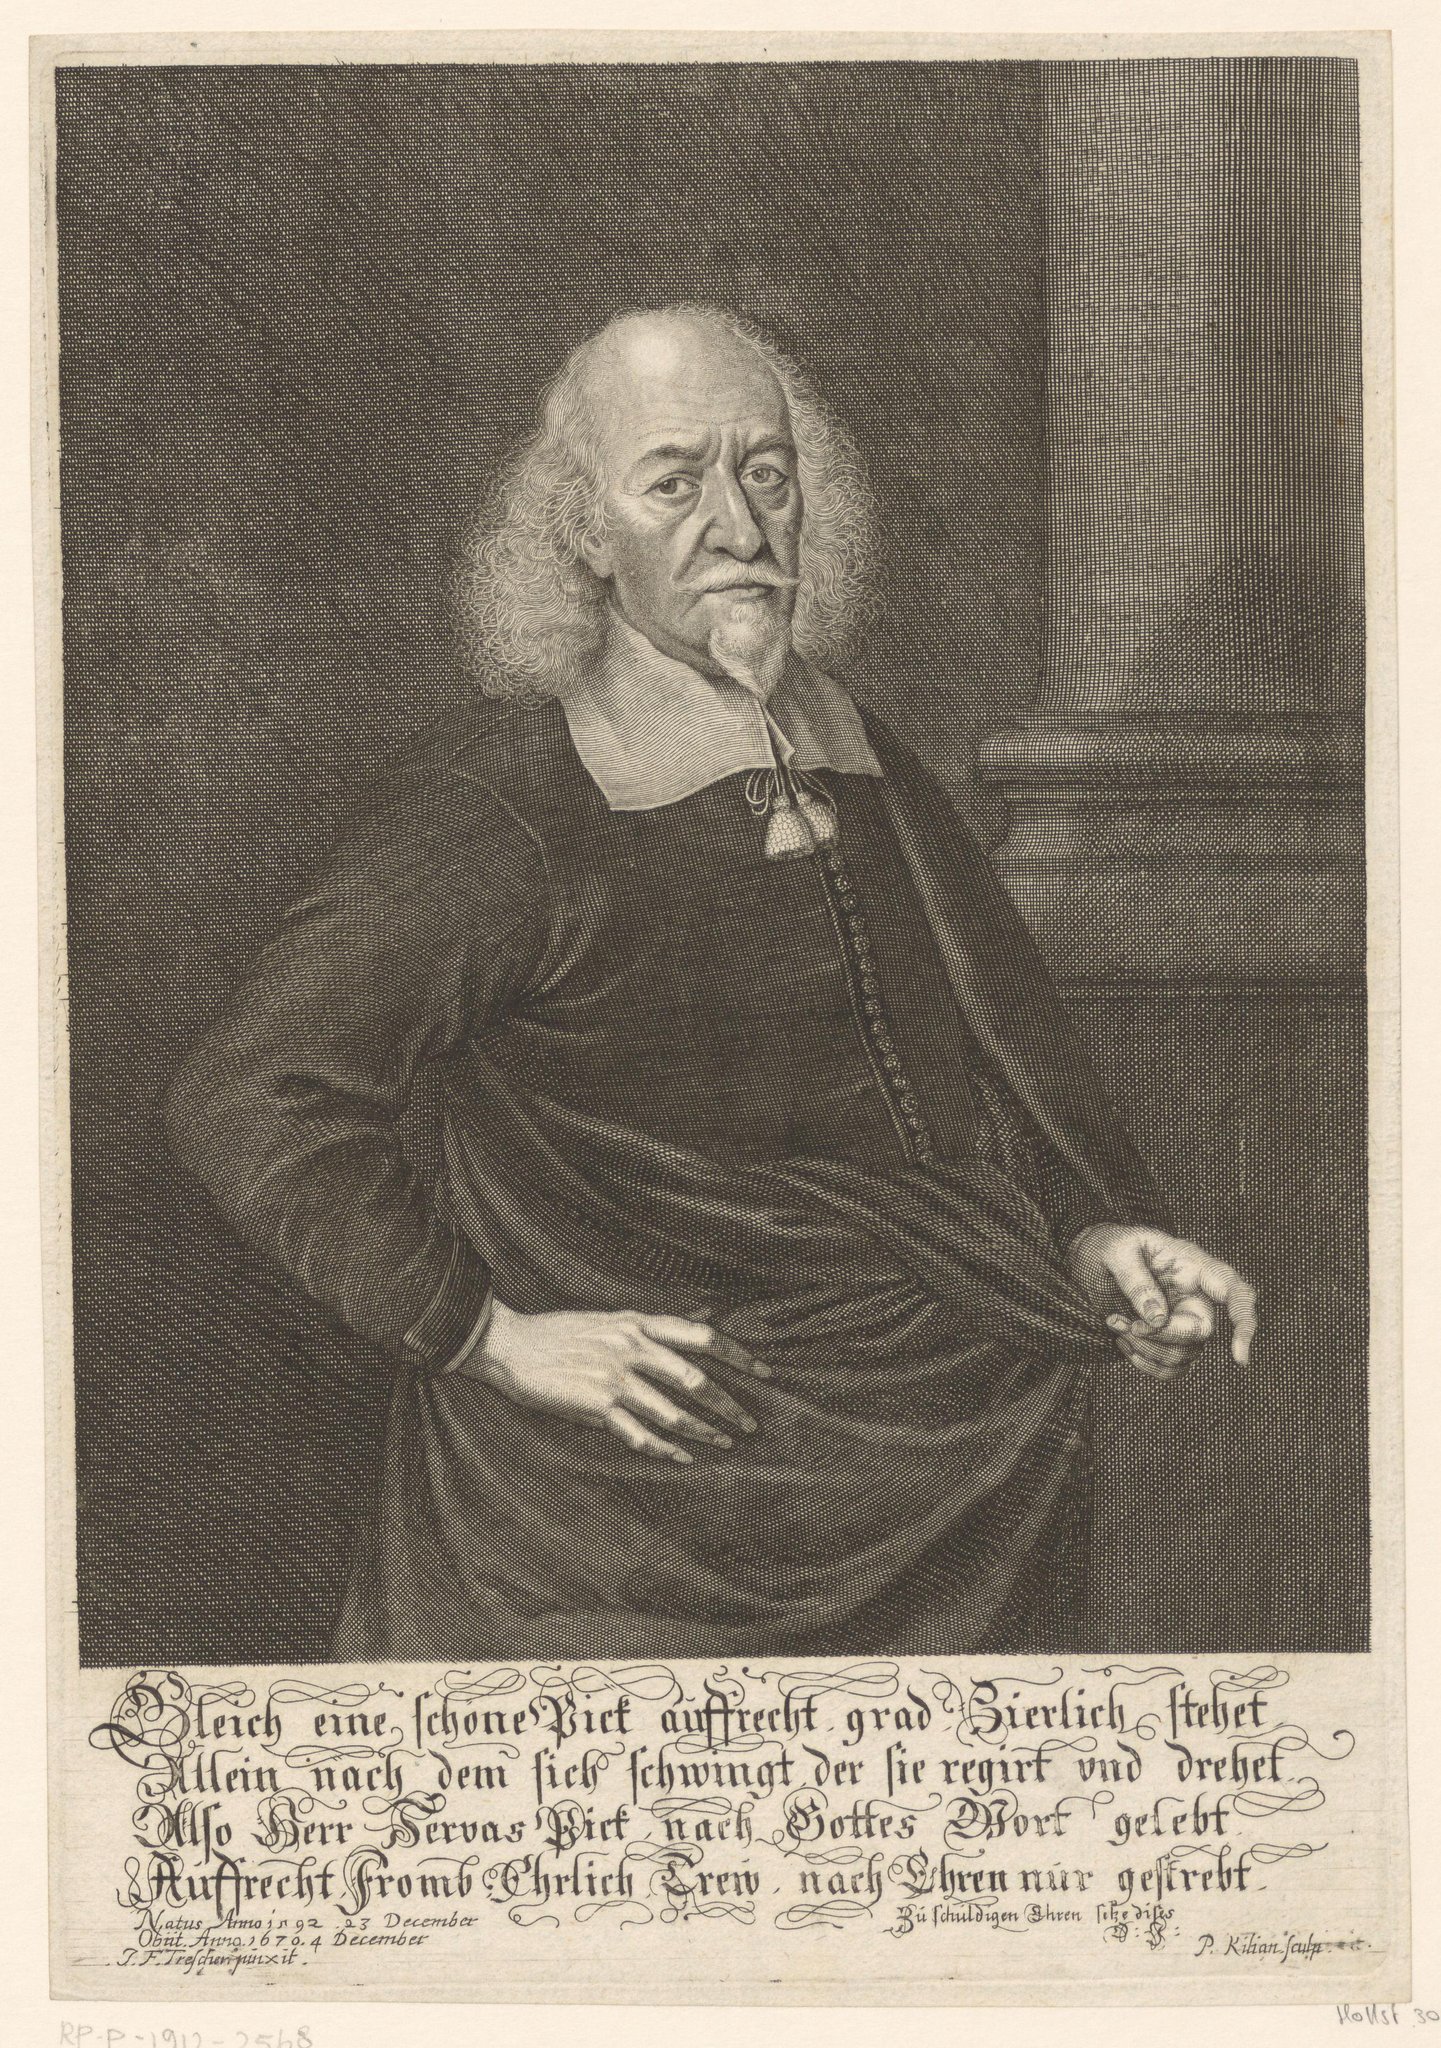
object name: print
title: Portret van Servas Pick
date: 1670-1693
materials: paper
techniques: engraving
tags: historical persons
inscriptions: collector's mark: Lugt 2228